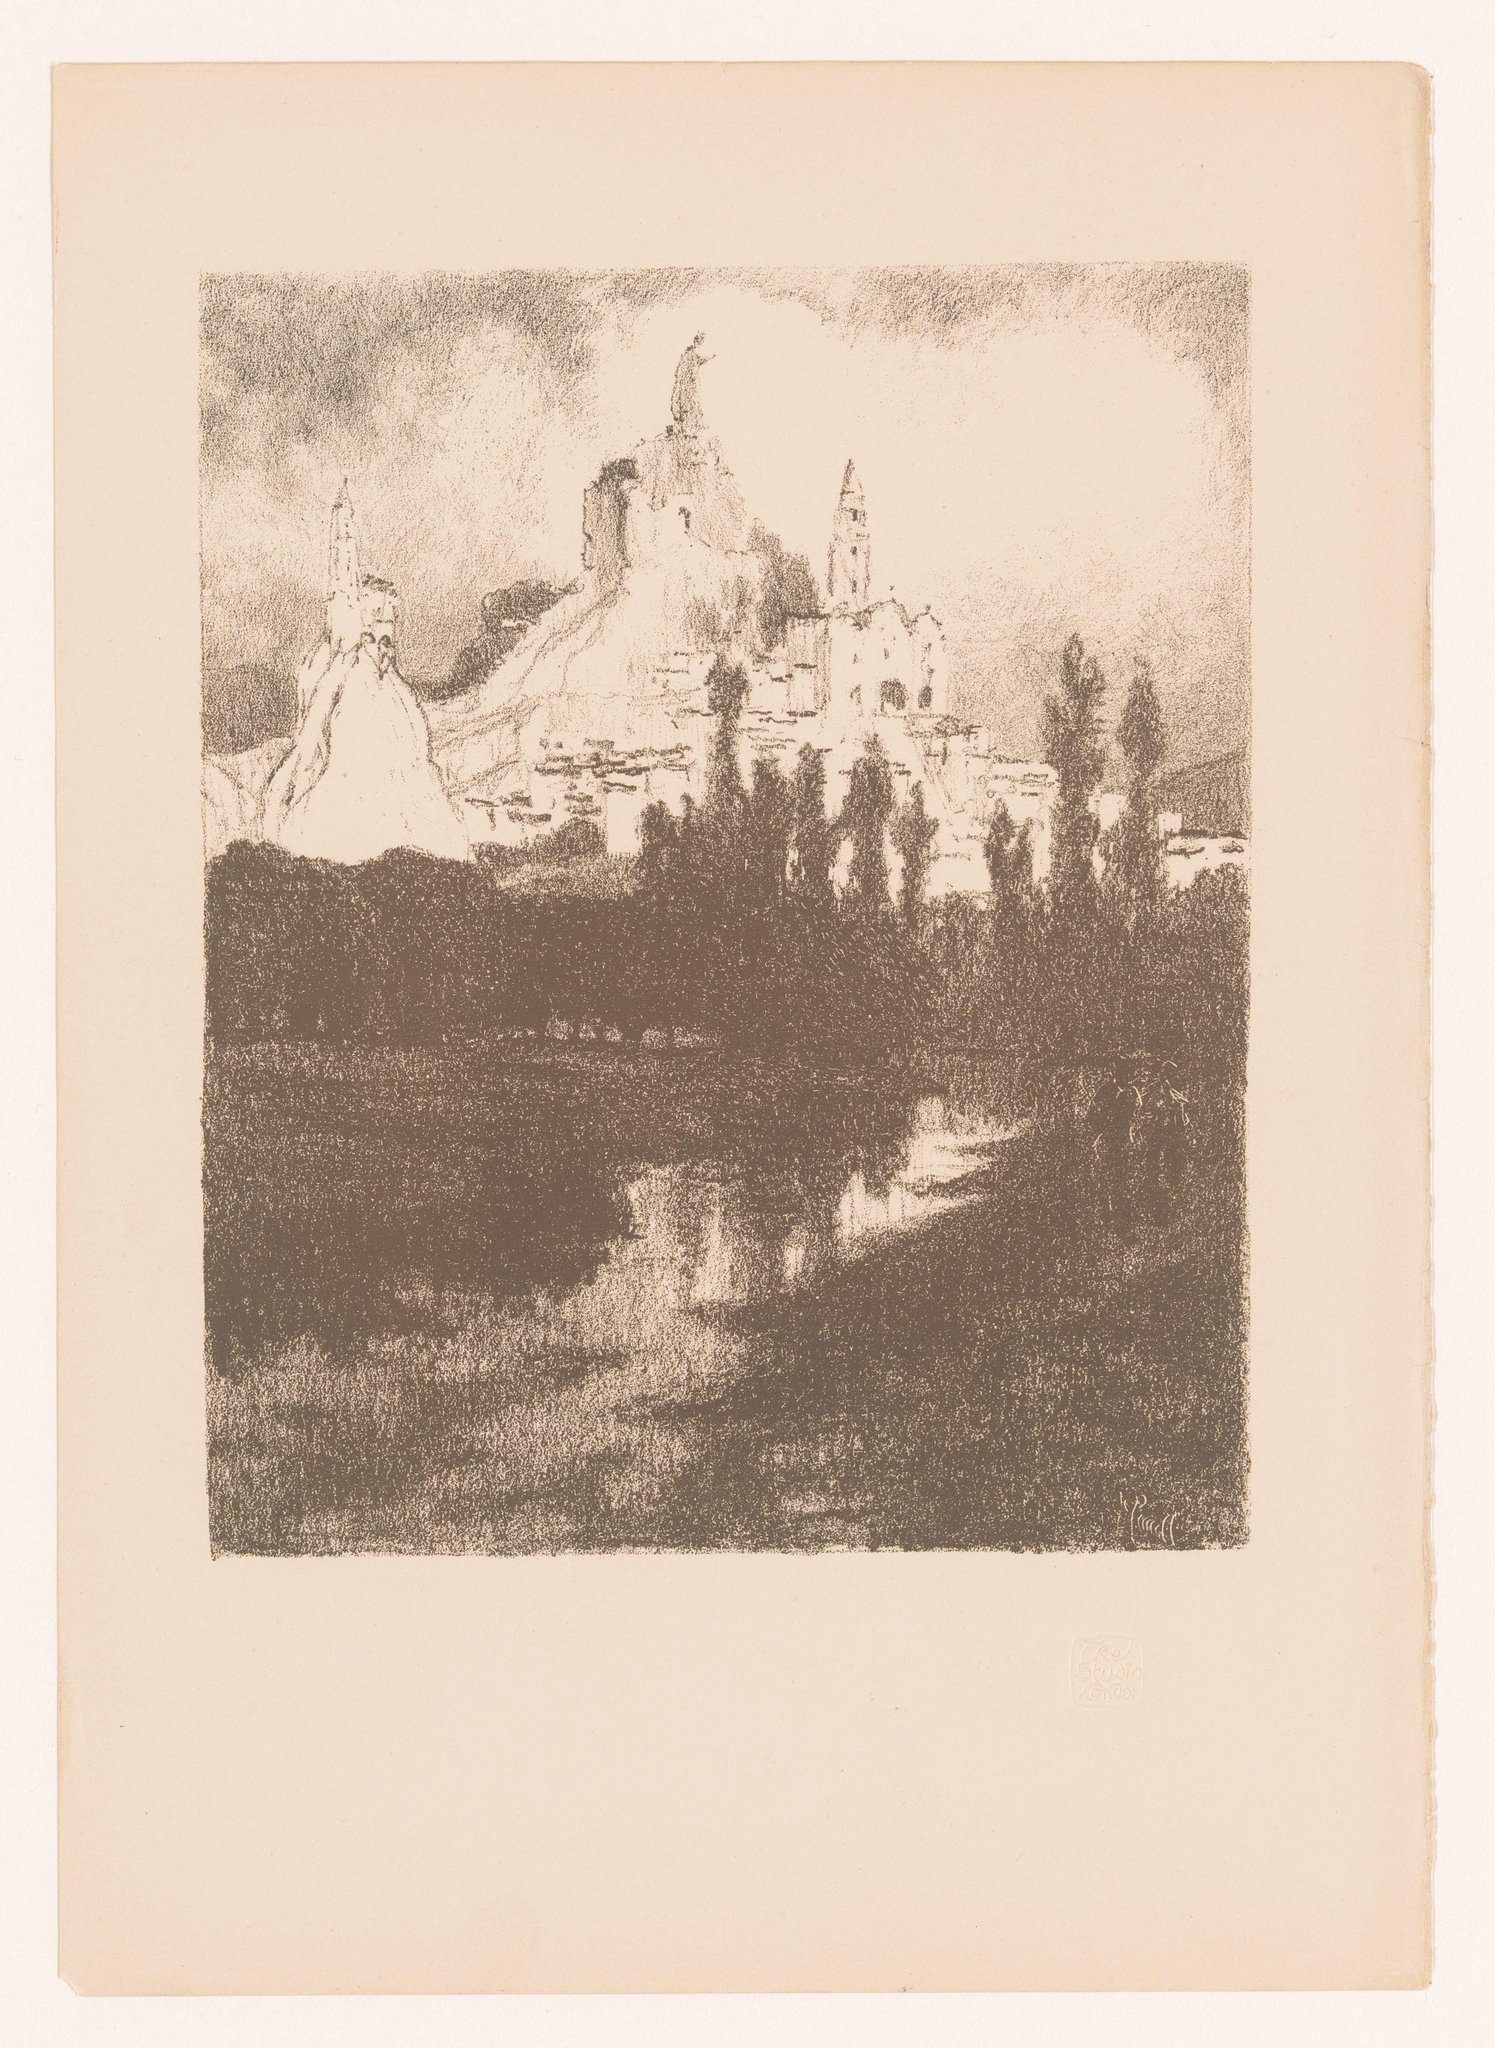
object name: print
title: Gezicht op Le Puy-en-Velay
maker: joseph pennell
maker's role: print maker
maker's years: 1857-1926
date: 1897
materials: paper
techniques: lithograph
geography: london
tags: city-view, and landscape with man-made constructions, landscapes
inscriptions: signature: ‘JoPennell’, check stamp: ‘The Studio London’ Lugt 2322bis, collector's mark: Lugt 2228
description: Prent gebruikt voor: The studio. An illustrated magazine of fine and applied art, vol. 10 (1897), p. 231. Met de titel 'A Castle on a Rock'.